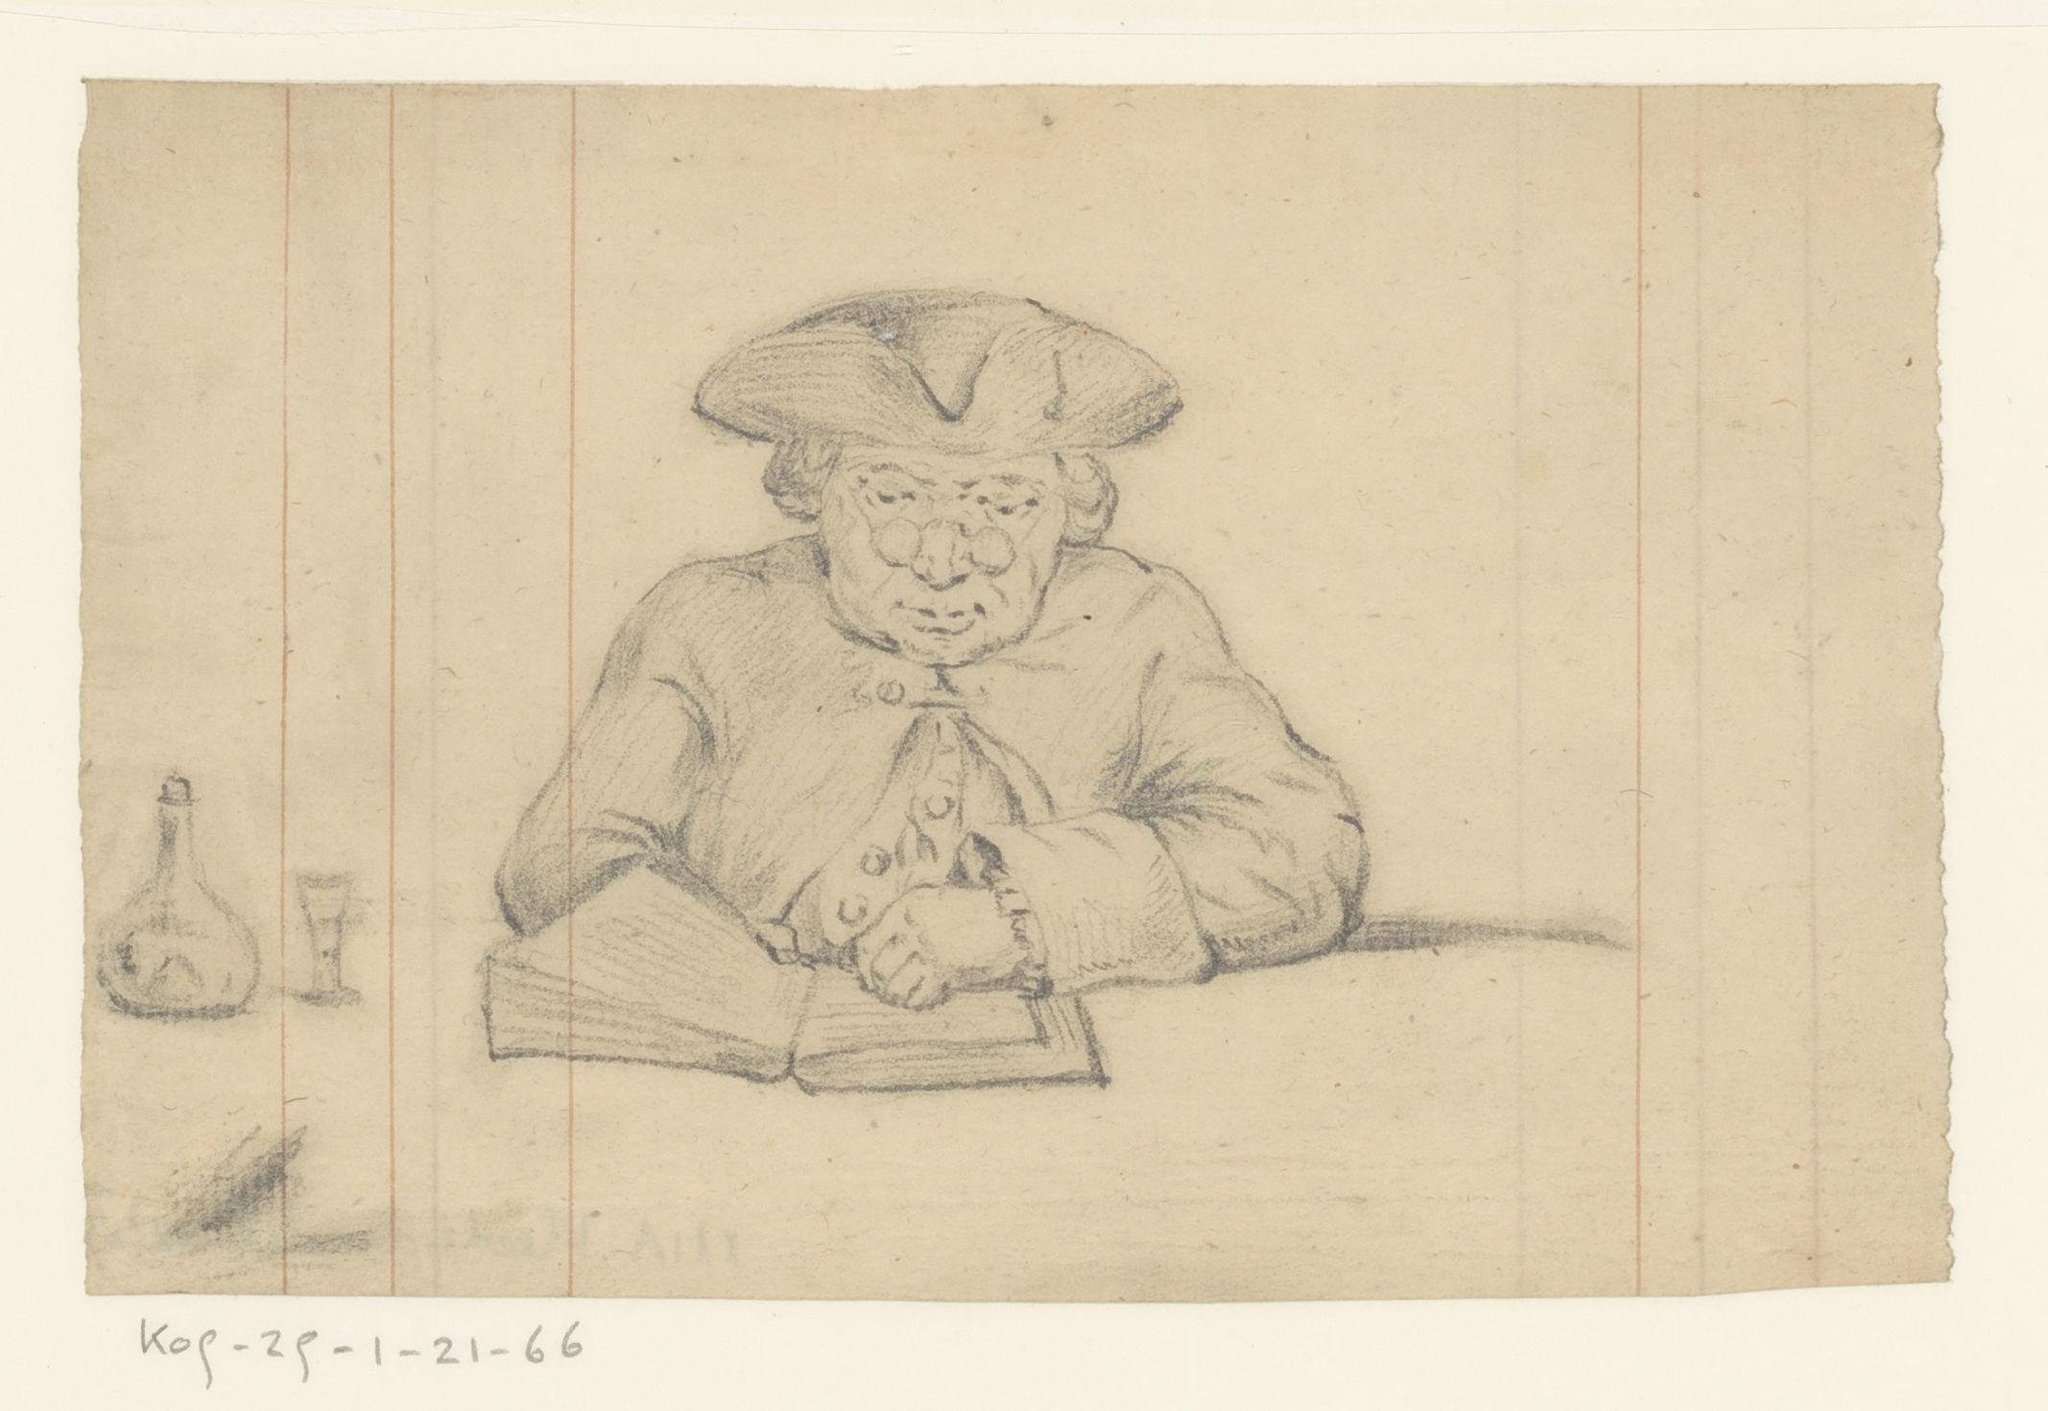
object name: drawing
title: Lezende oude man met bril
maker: jean bernard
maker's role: draughtsman, print maker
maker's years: 1765-1833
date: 1775-1833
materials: chalk, paper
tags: eyeglasses, spectacles, reading, head-gear: tricorn, old man, bottle of wine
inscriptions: collector's mark: Lugt 1641, stamp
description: Een lezende oude man met bril zit aan tafel. Op zijn hoofd een driekantige steek. Aan de linkerkant een fles wijn en een glas. Onderwerpsrubrieken binnen de Atlas Zeden en Gewoonten: Zeden en Gewoonten in Engeren Zin, De Kleeding, Kleederdrachten (tijdvakken), De 18de eeuw (de pruikentijd). Mannen en vrouwen.